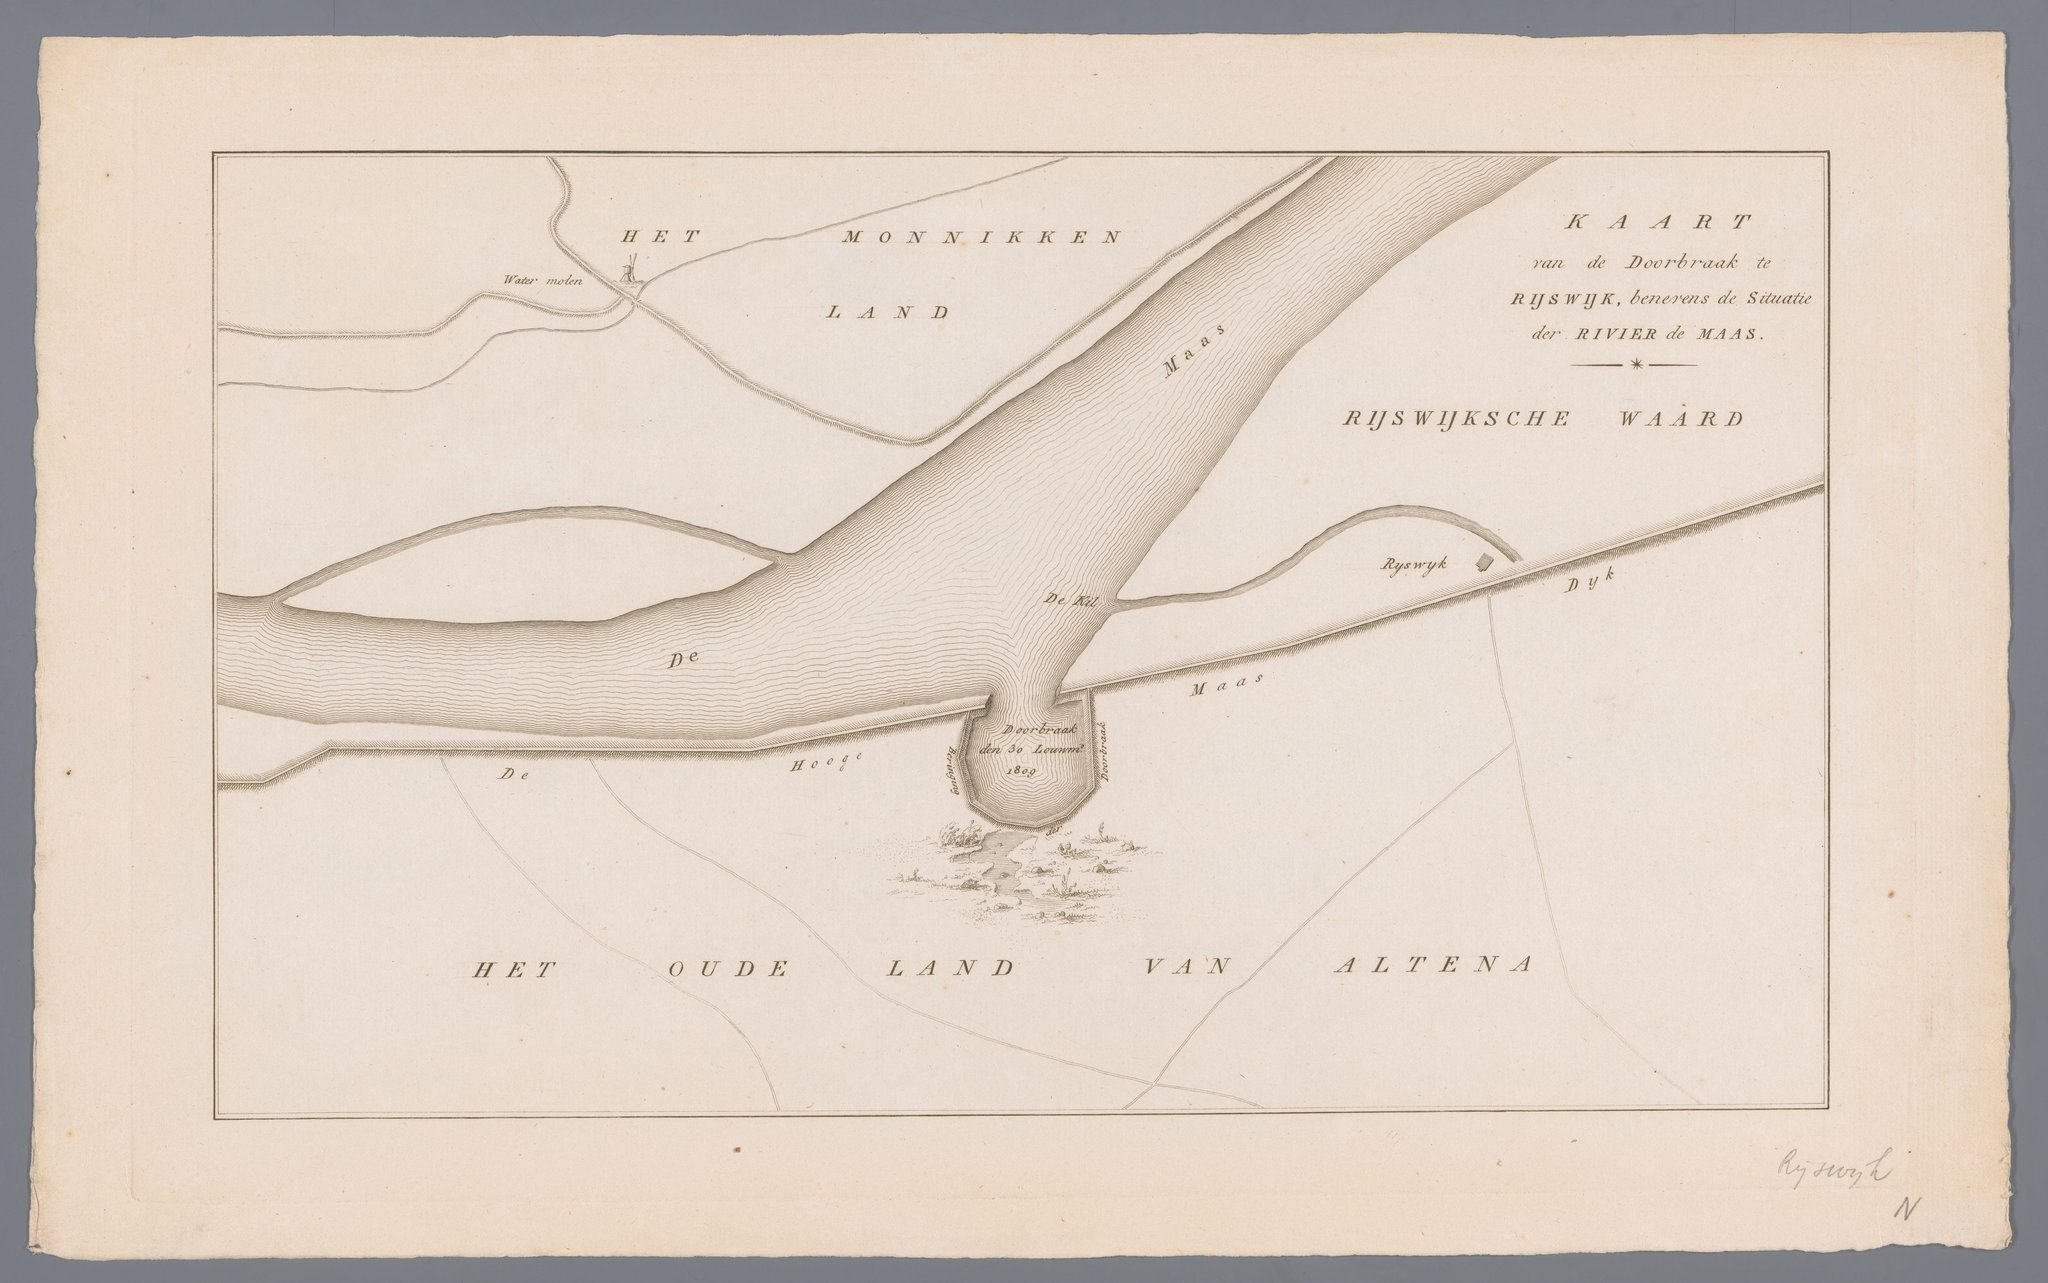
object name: book illustration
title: Kaart van dijkdoorbraak te Rijswijk, 1809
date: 1809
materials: paper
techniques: etching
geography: amsterdam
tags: dike-break, maps of separate countries or regions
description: Prent uit: Ewijk, Hendrik. Geschiedkundig verslag der dijkbreuken en overstroomingen, langs de rivieren in het Koningrijk Holland, voorgevallen in louwmaand MDCCCIX. Amsterdam: Johannes Allart en Jacobus Ruys, 1809.